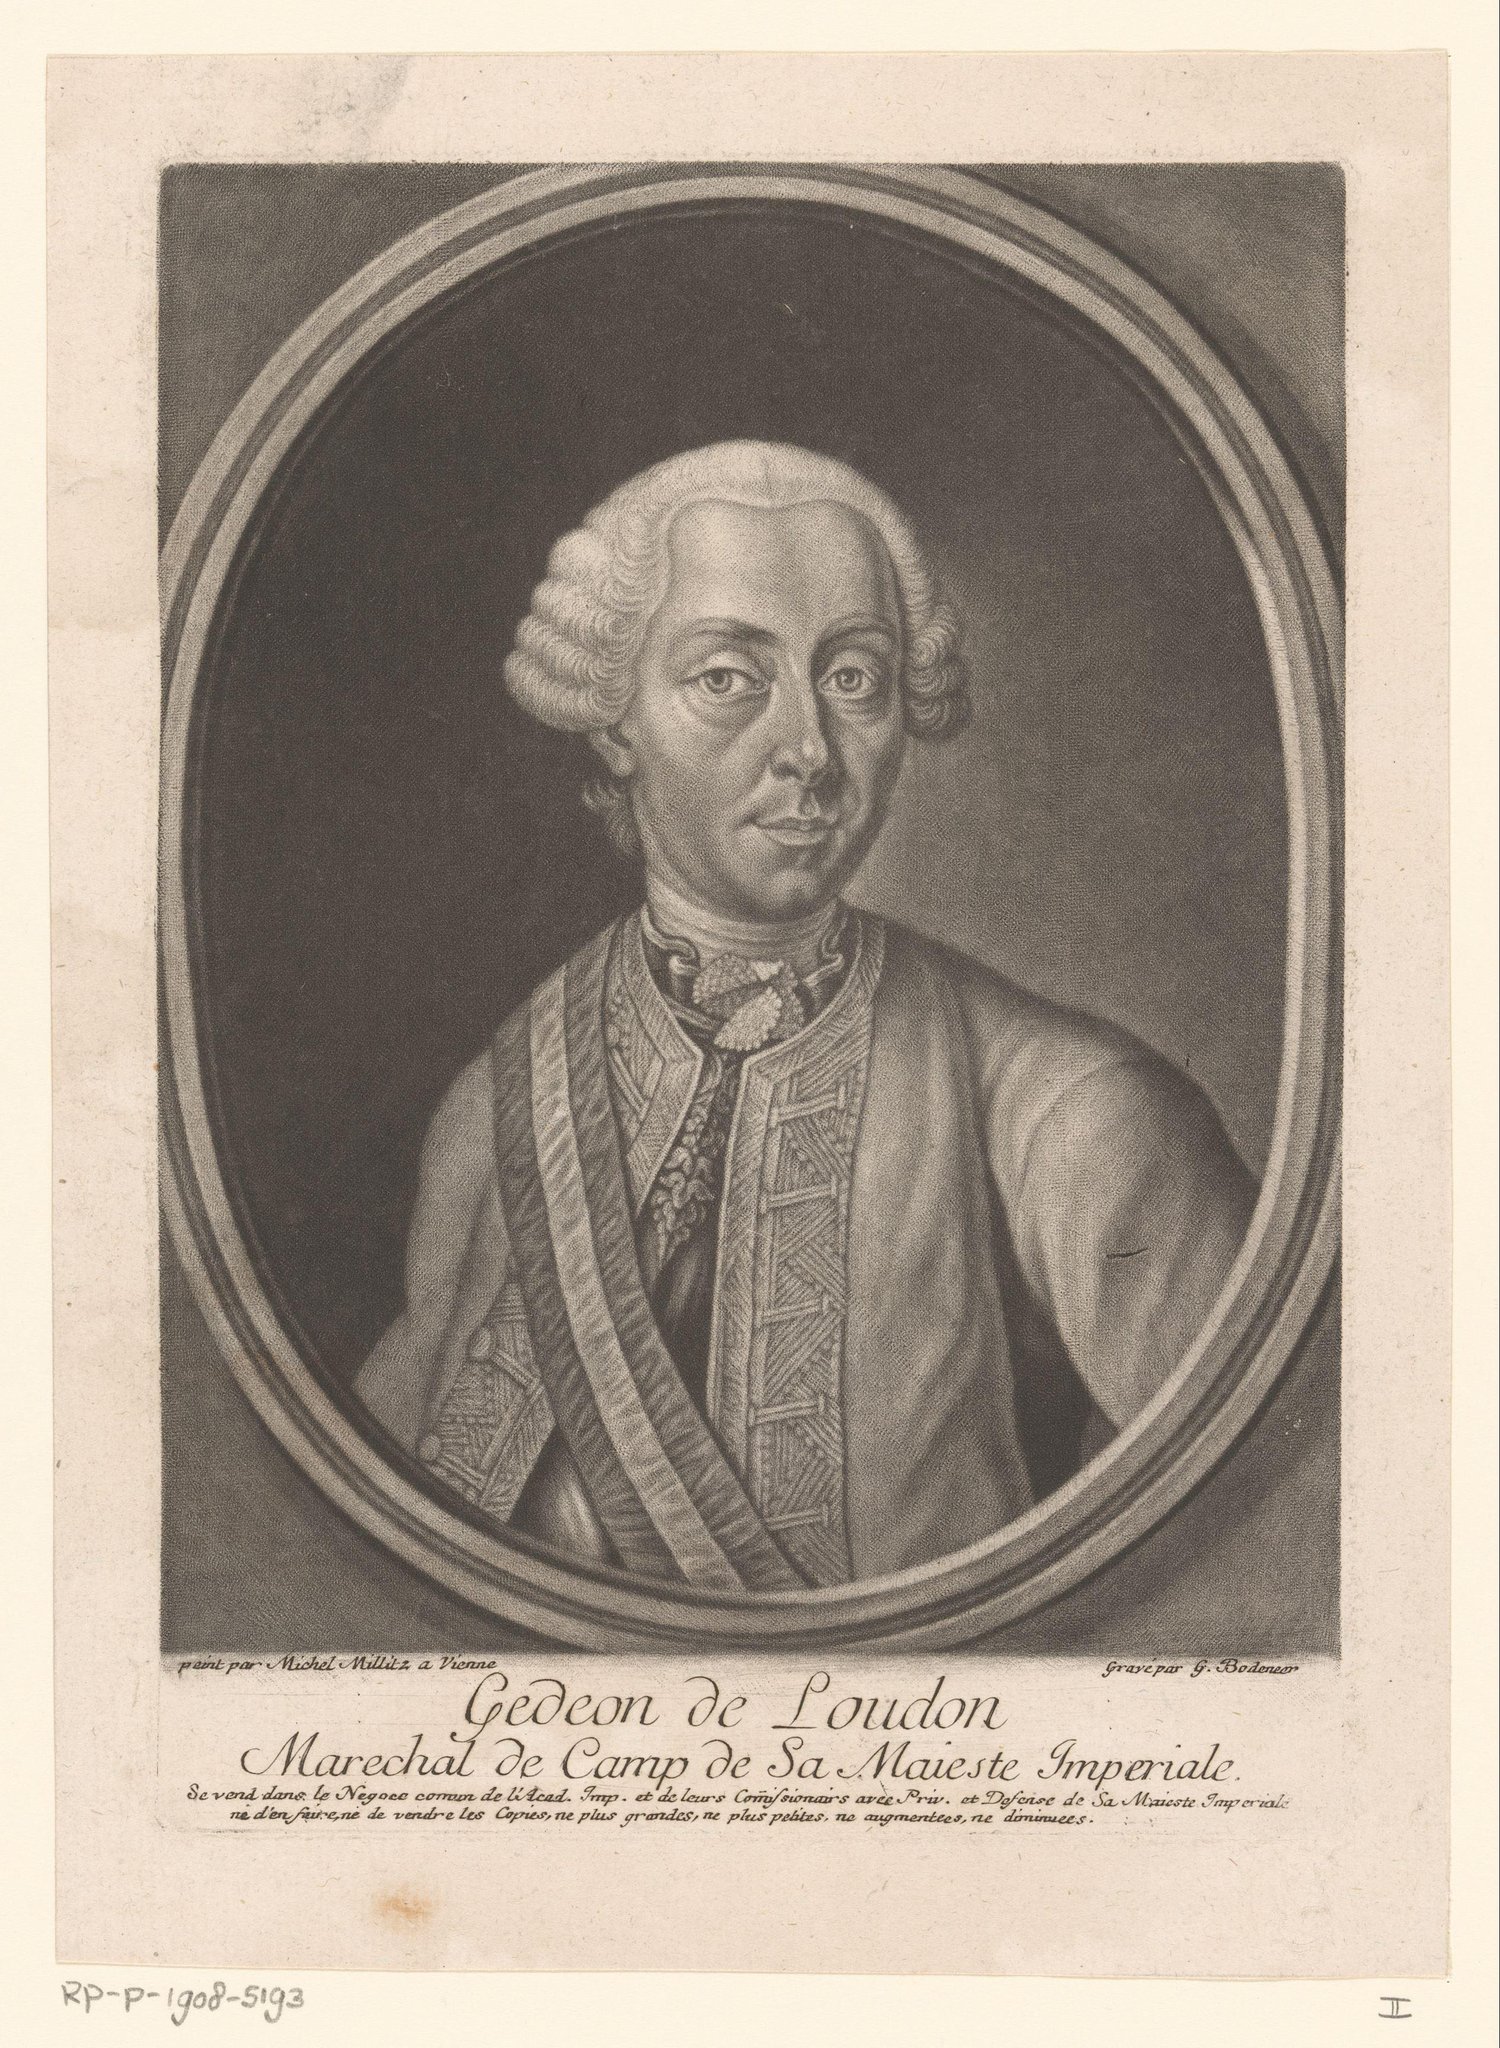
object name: print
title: Portret van Ernst Gideon von Laudon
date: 1727-1790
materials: paper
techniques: mezzotint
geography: vienna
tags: historical persons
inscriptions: collector's mark: Lugt 2228